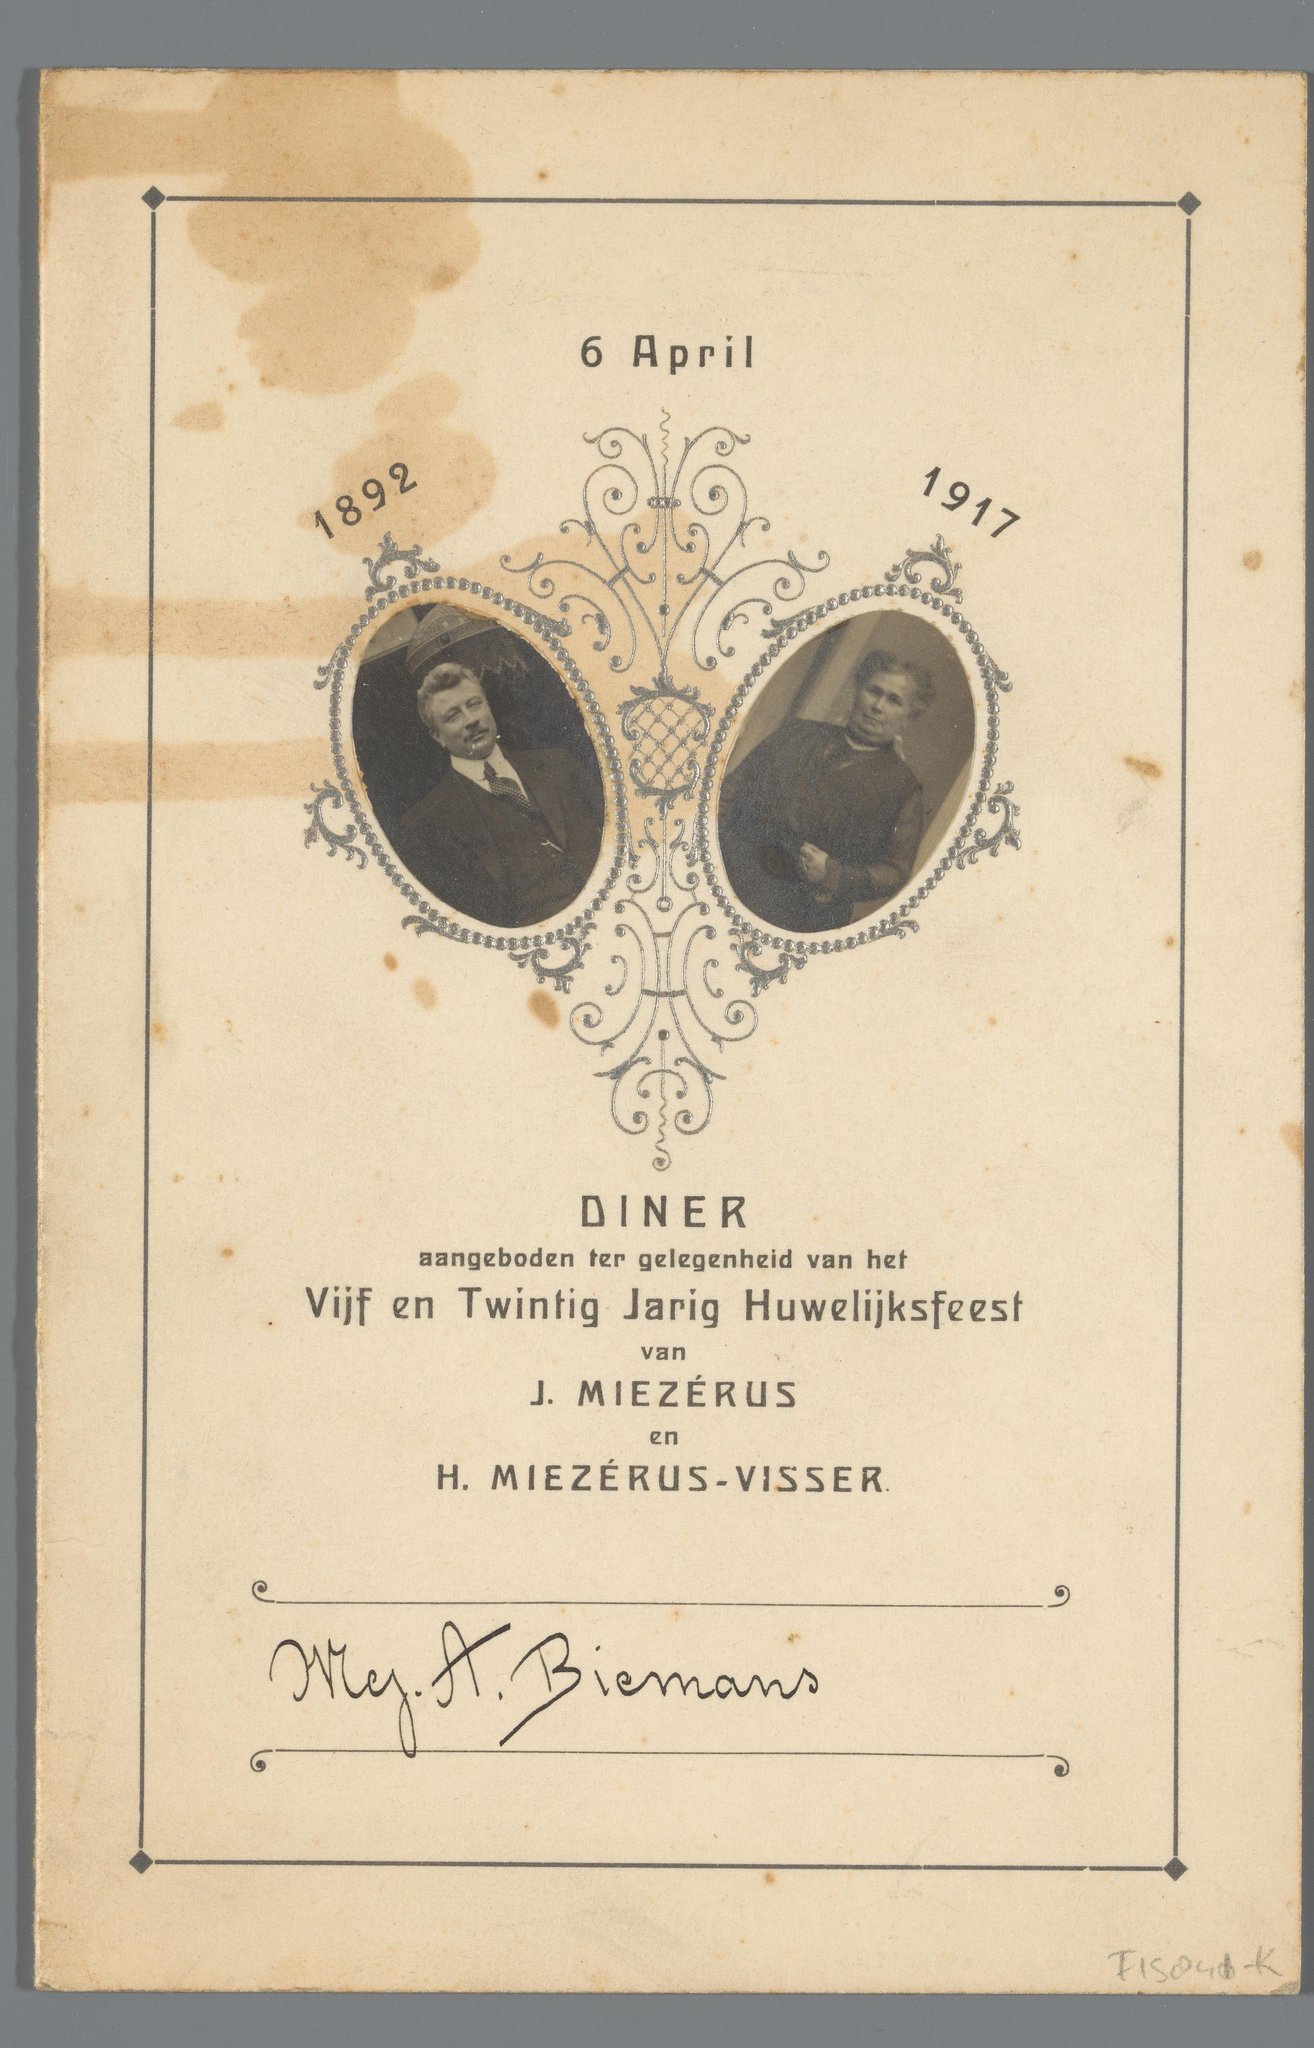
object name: photograph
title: Menukaart voor een diner ter ere van het 25-jarig huwelijksfeest van J. Miezérus en H. Miezérus-Visser, met portretten van het echtpaar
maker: Anonymous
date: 1917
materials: paper, ink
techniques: gelatin silver print, letterpress printing, pen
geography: netherlands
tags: haarlem, historical persons, couple of lovers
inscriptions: inscription: ‘6 April/ 1892 1917/ Diner/ aangeboden ter gelegenheid van het/ Vijf en Twintig Jarig Huwelijksfeest/ van/ J. Miezérus/ en H. Miezérus-Visser’, inscription: ‘Mej. A. Biemans’, inscription: ‘Menu/ (...) Restaurant Brinkmann.’